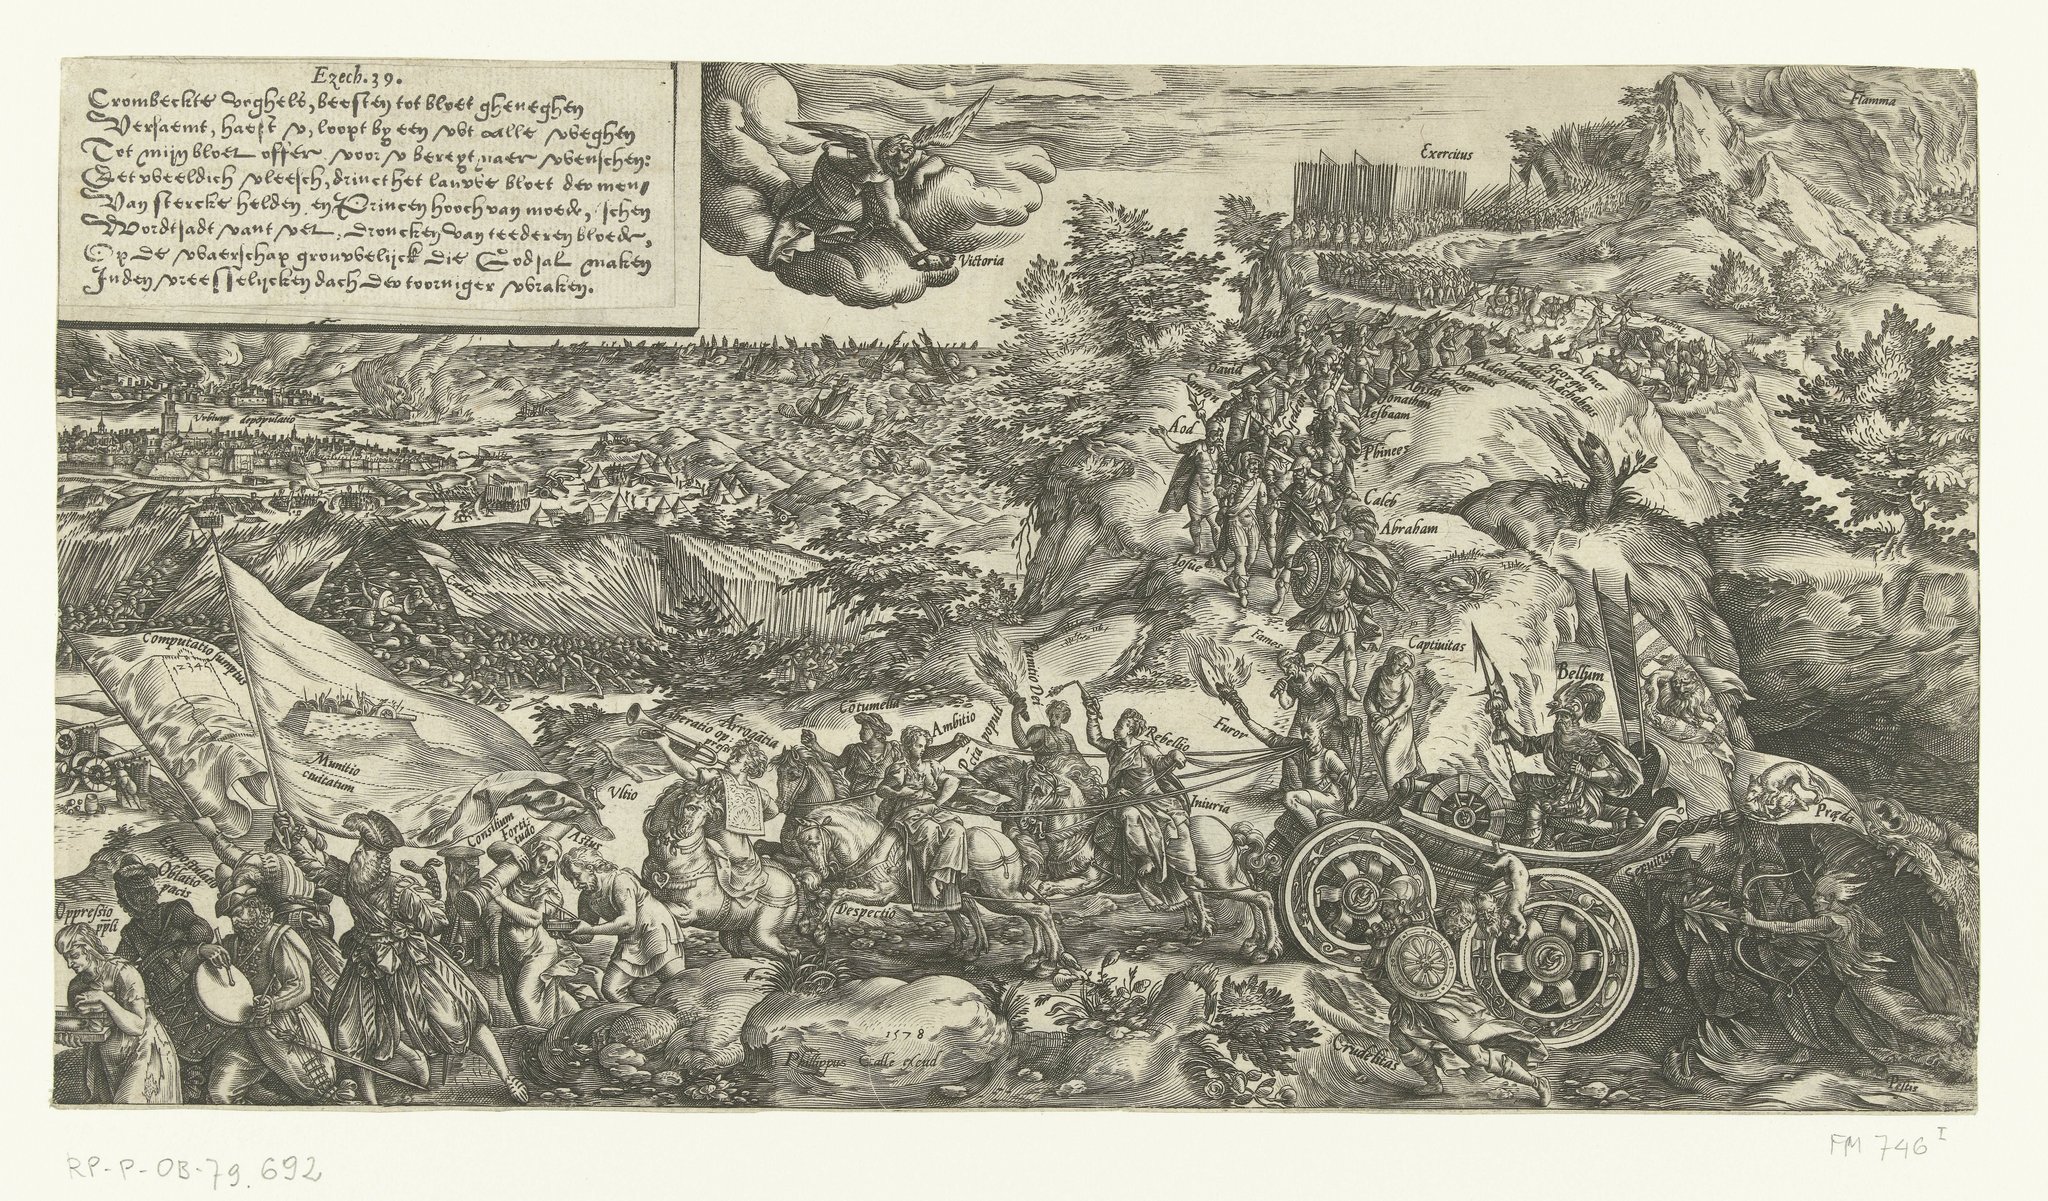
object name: print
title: De triomfwagen van de Oorlog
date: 1578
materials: paper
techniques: engraving, letterpress printing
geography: northern netherlands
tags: symbols, allegories of war; 'guerra' (ripa)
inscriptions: date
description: Allegorie op de oorzaken en gevolgen van de oorlog. De personificatie van de Oorlog (Bellum) rijdt op een zegewagen getrokken door vier paarden, vooraan een stoet van personificaties van verschillende elementen die voorafgaan aan het uitbreken van de oorlog. Van boven uit de bergen komt een stoet met helden en beroemde legeraanvoerders uit het oude testament. Links het land en de zee geteisterd door oorlog. In de wolken de personificatie Overwinning (Victoria) met een lauwerkrans. In de cartouche linksboven is een papier met een bijbeltekst geplakt.